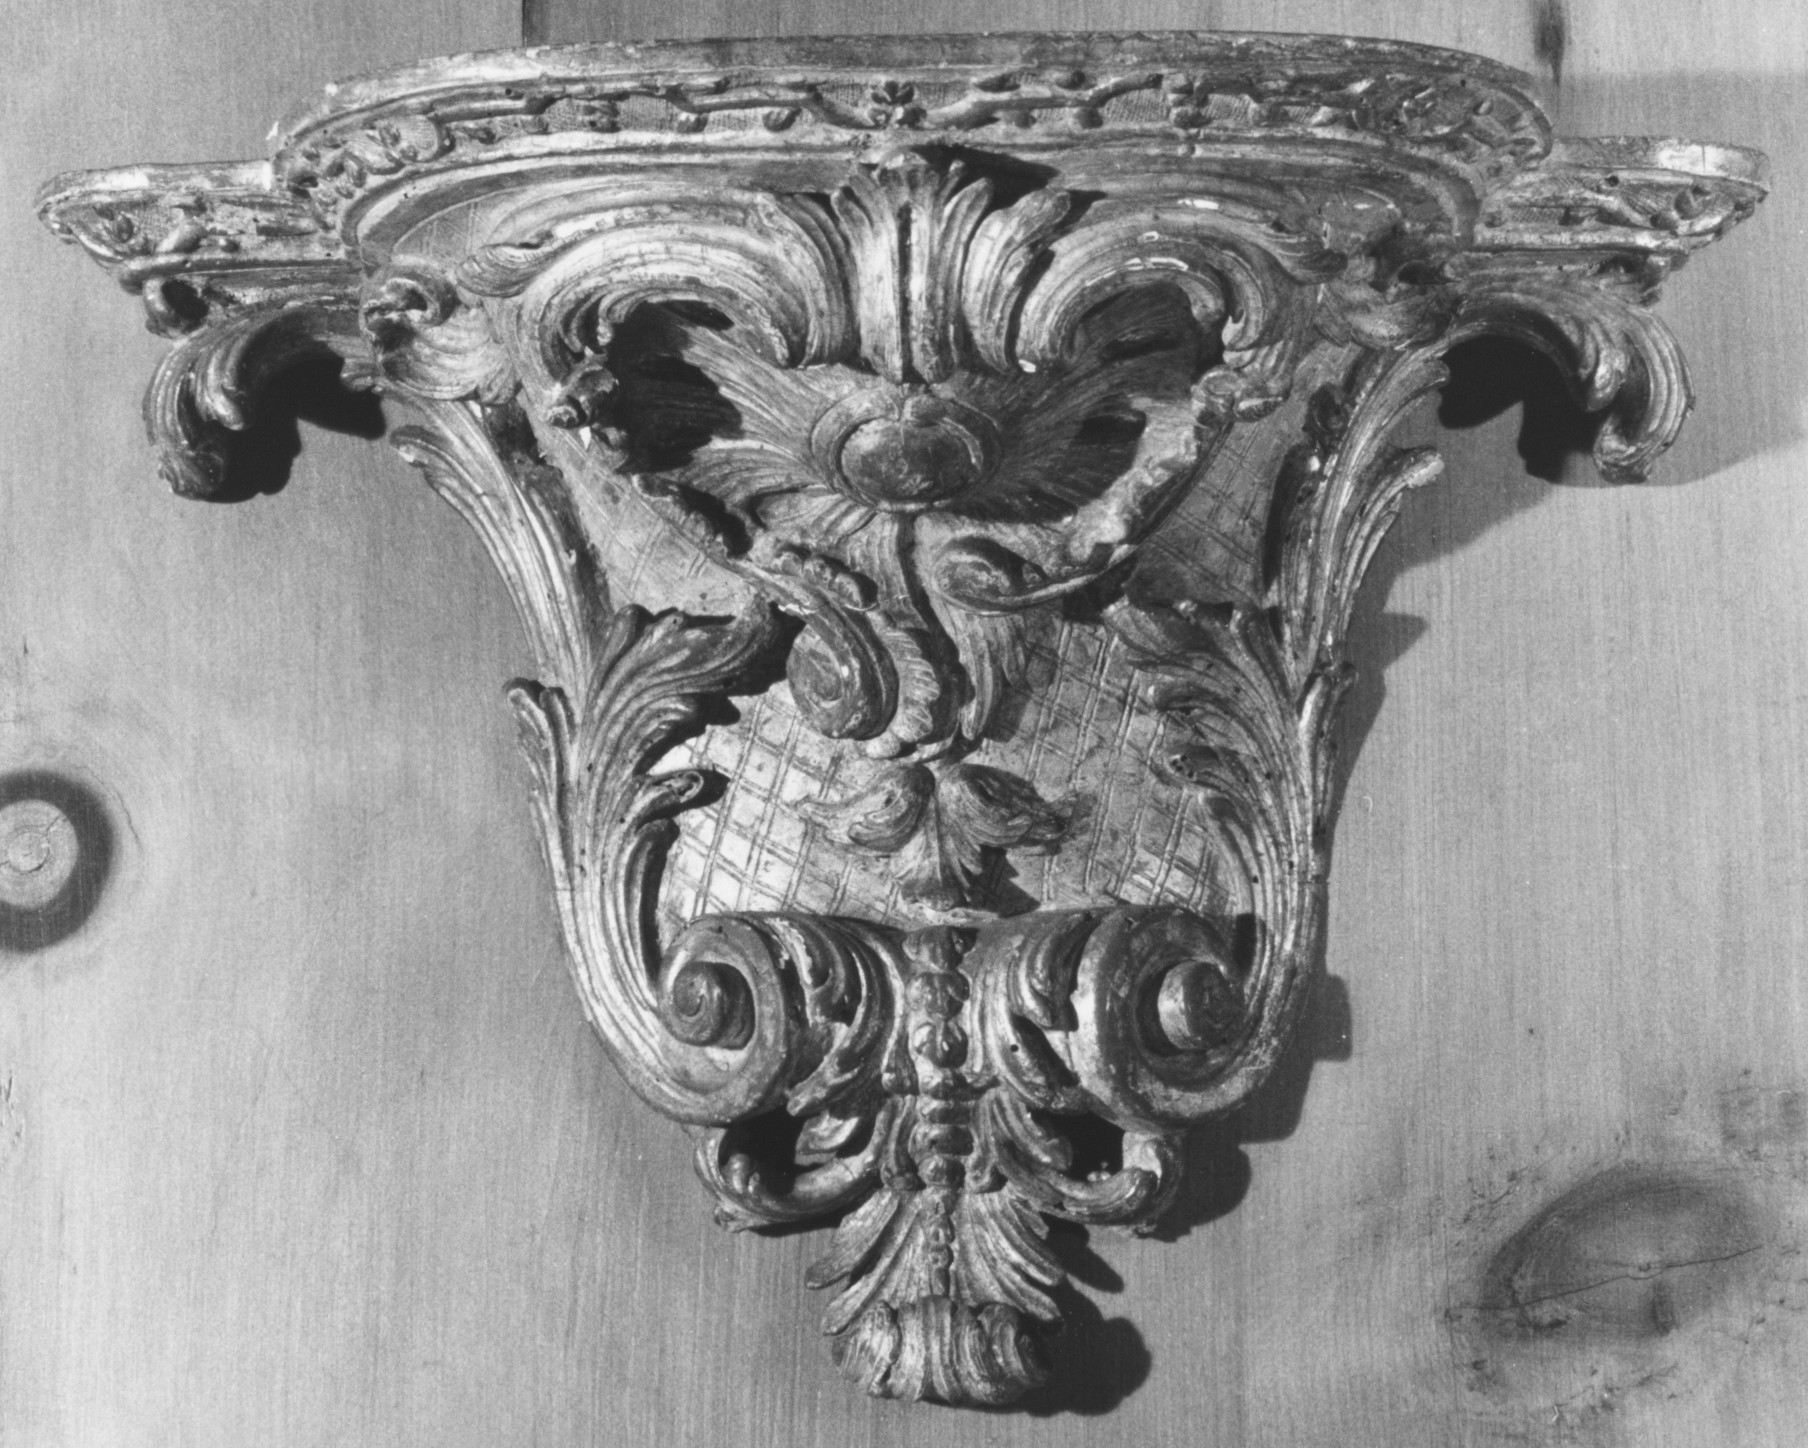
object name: wall bracket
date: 1730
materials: wood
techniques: carving, gilding